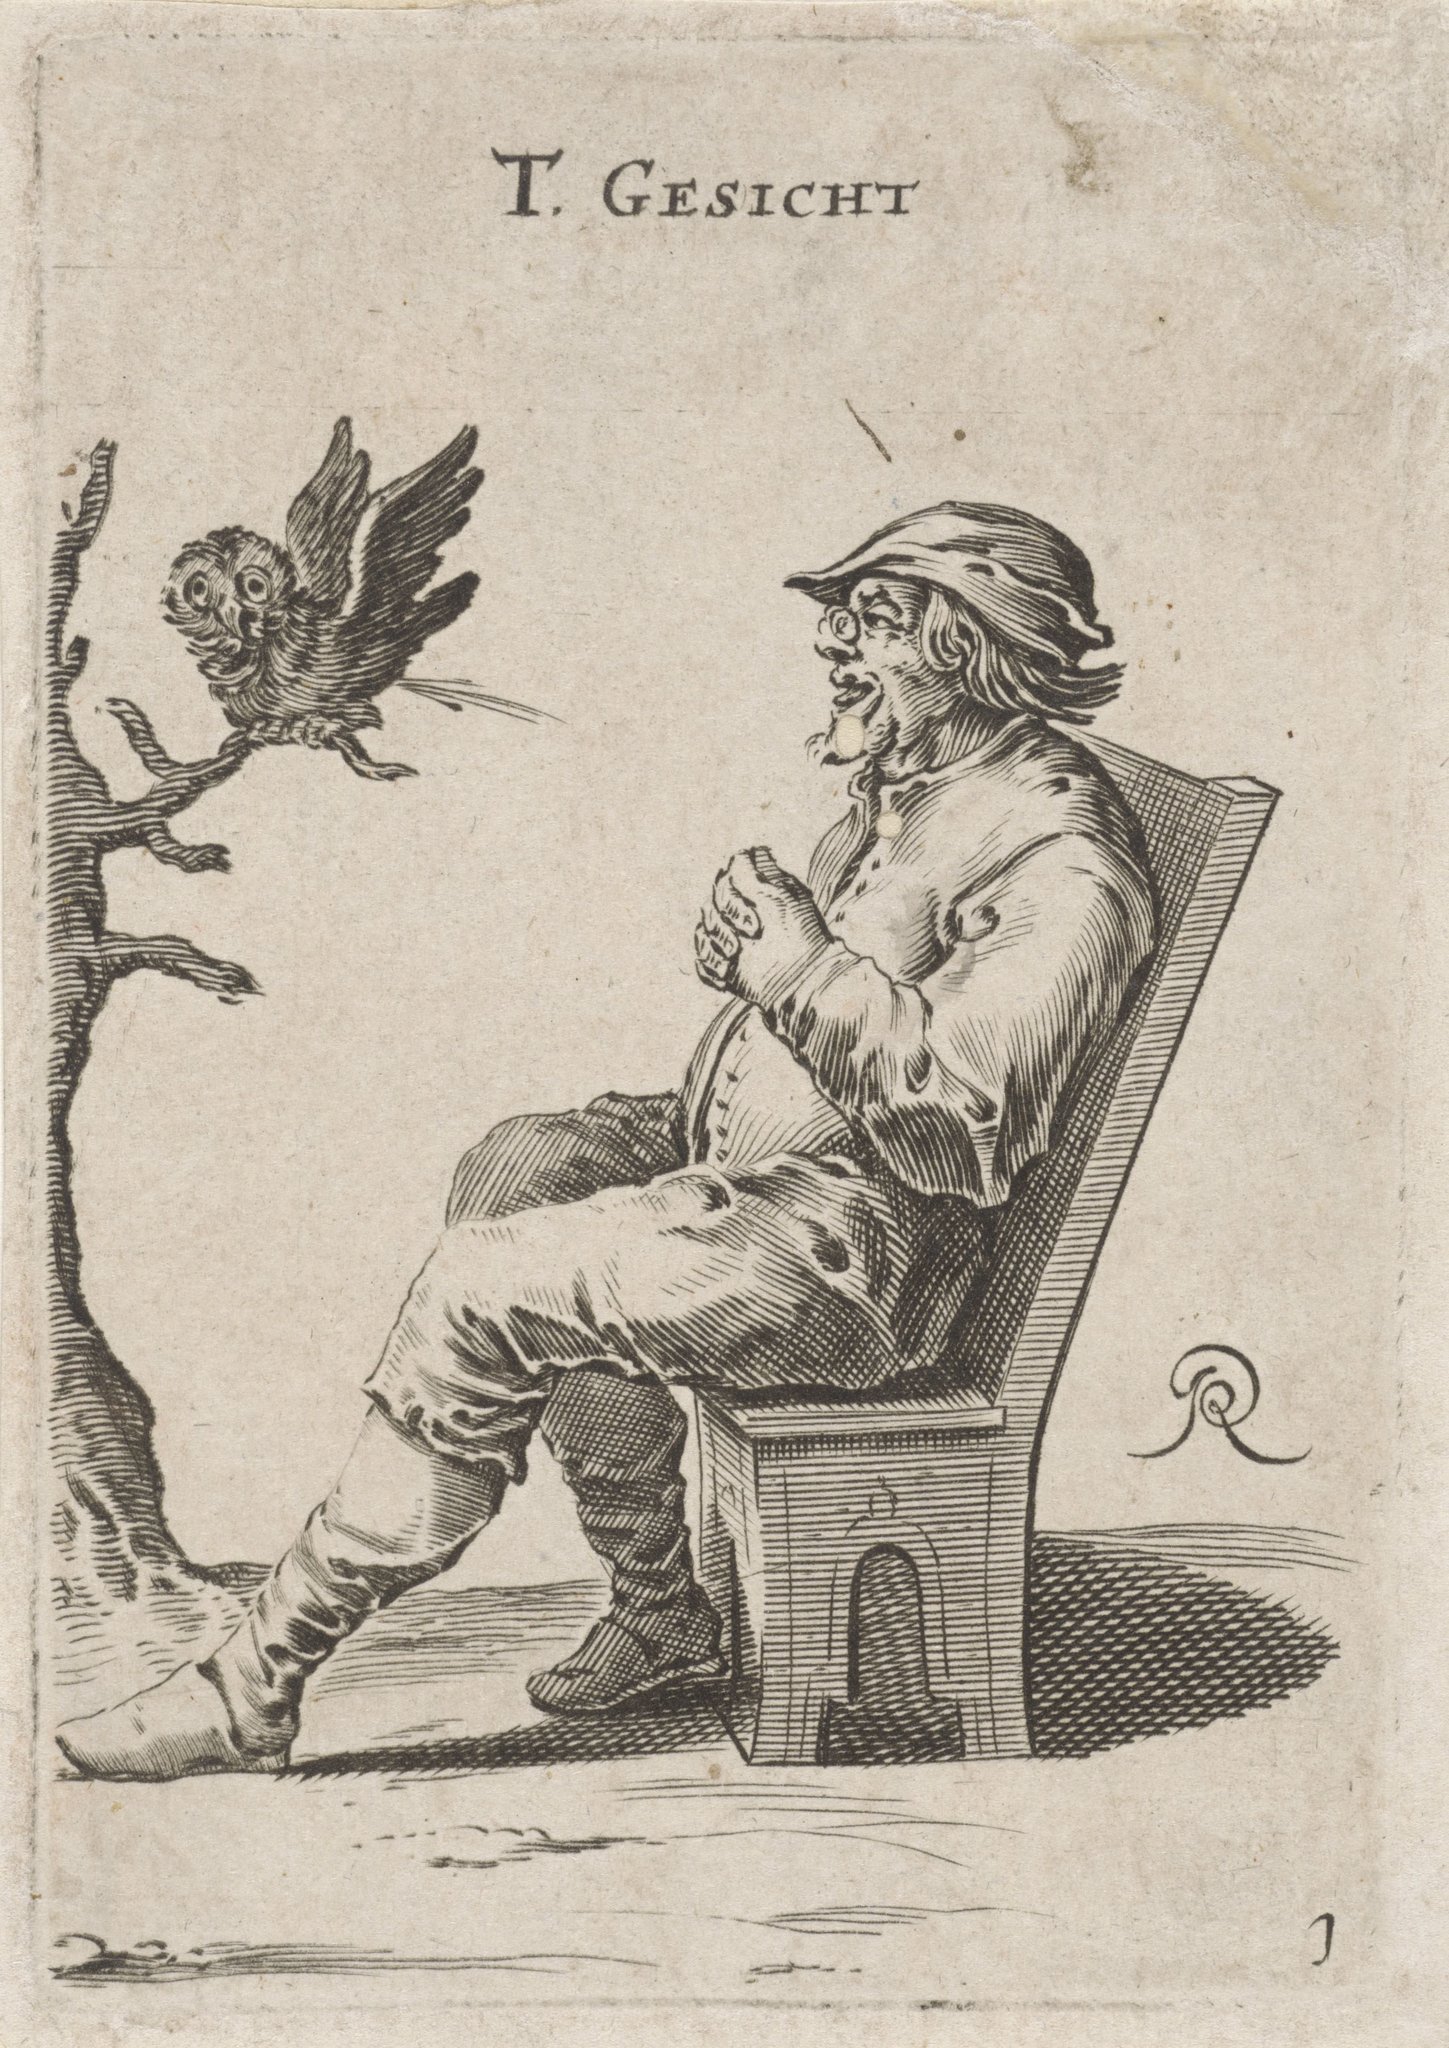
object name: print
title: T. Gesicht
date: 1638-1665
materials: paper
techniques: engraving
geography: amsterdam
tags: eyeglasses, spectacles, sight, looking (one of the five senses), owls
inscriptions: collector's mark: Lugt 2228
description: Op een stoel zit een man met bril op naar een uil te kijken die voor hem op een stok zit. De prent maakt deel uit van een zesdelige serie prenten met voorstellingen van de vijf zintuigen (ongenummerde titelprent).